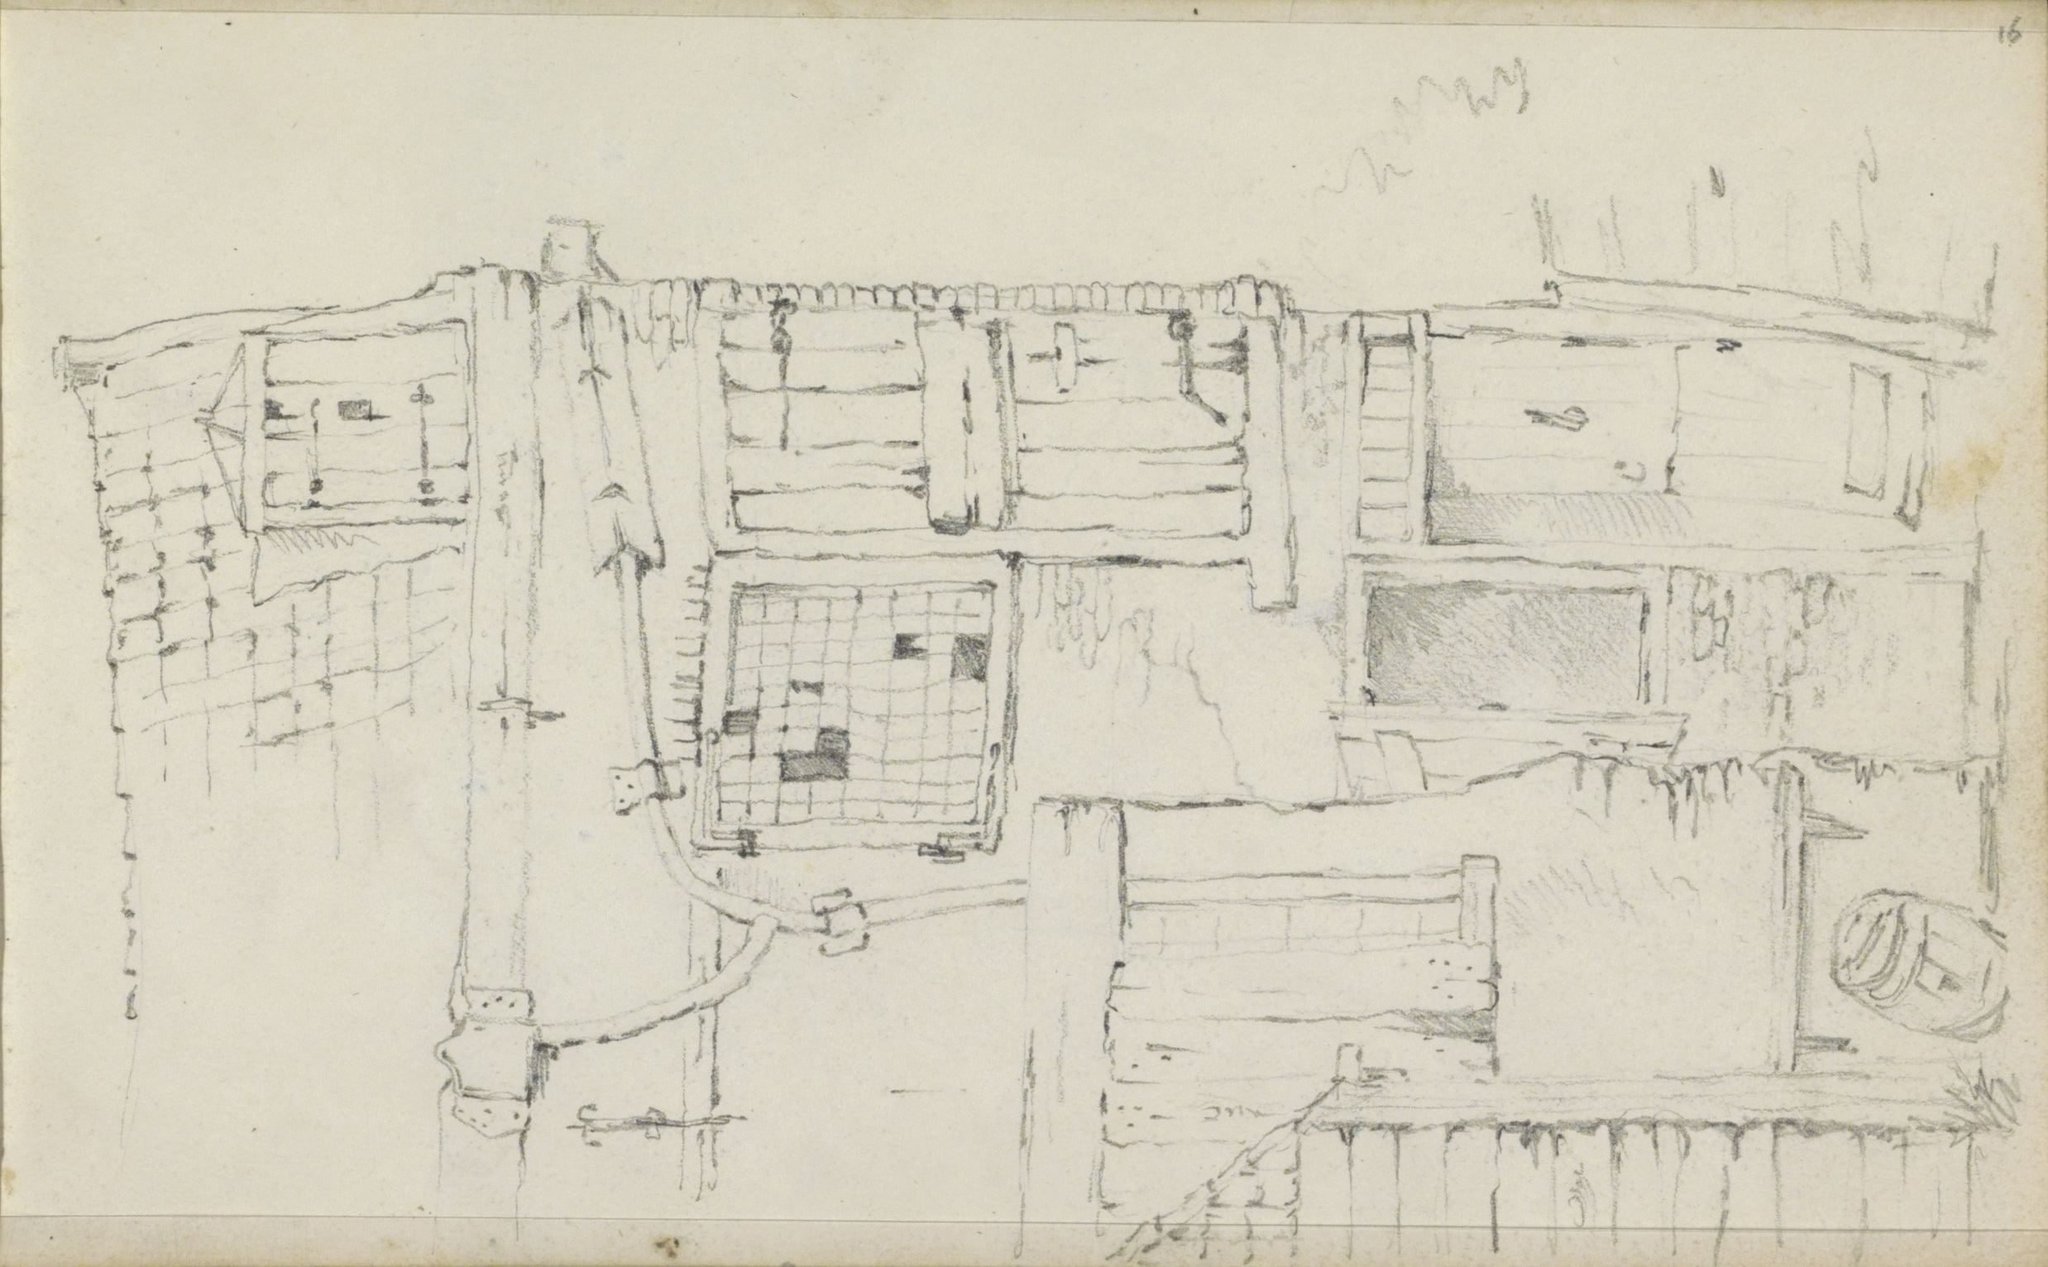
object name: sketchbook leaf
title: Vervallen gebouw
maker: adrianus eversen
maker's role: draughtsman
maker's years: 1818-1897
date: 1828-1897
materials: paper, pencil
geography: netherlands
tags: housing, ruin of a dwelling, house, castle, etc.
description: Gezicht op een vervallen gebouw. Voor het gebouw een scheve ton. Blad 16 recto uit een schetsboek met 27 bladen.